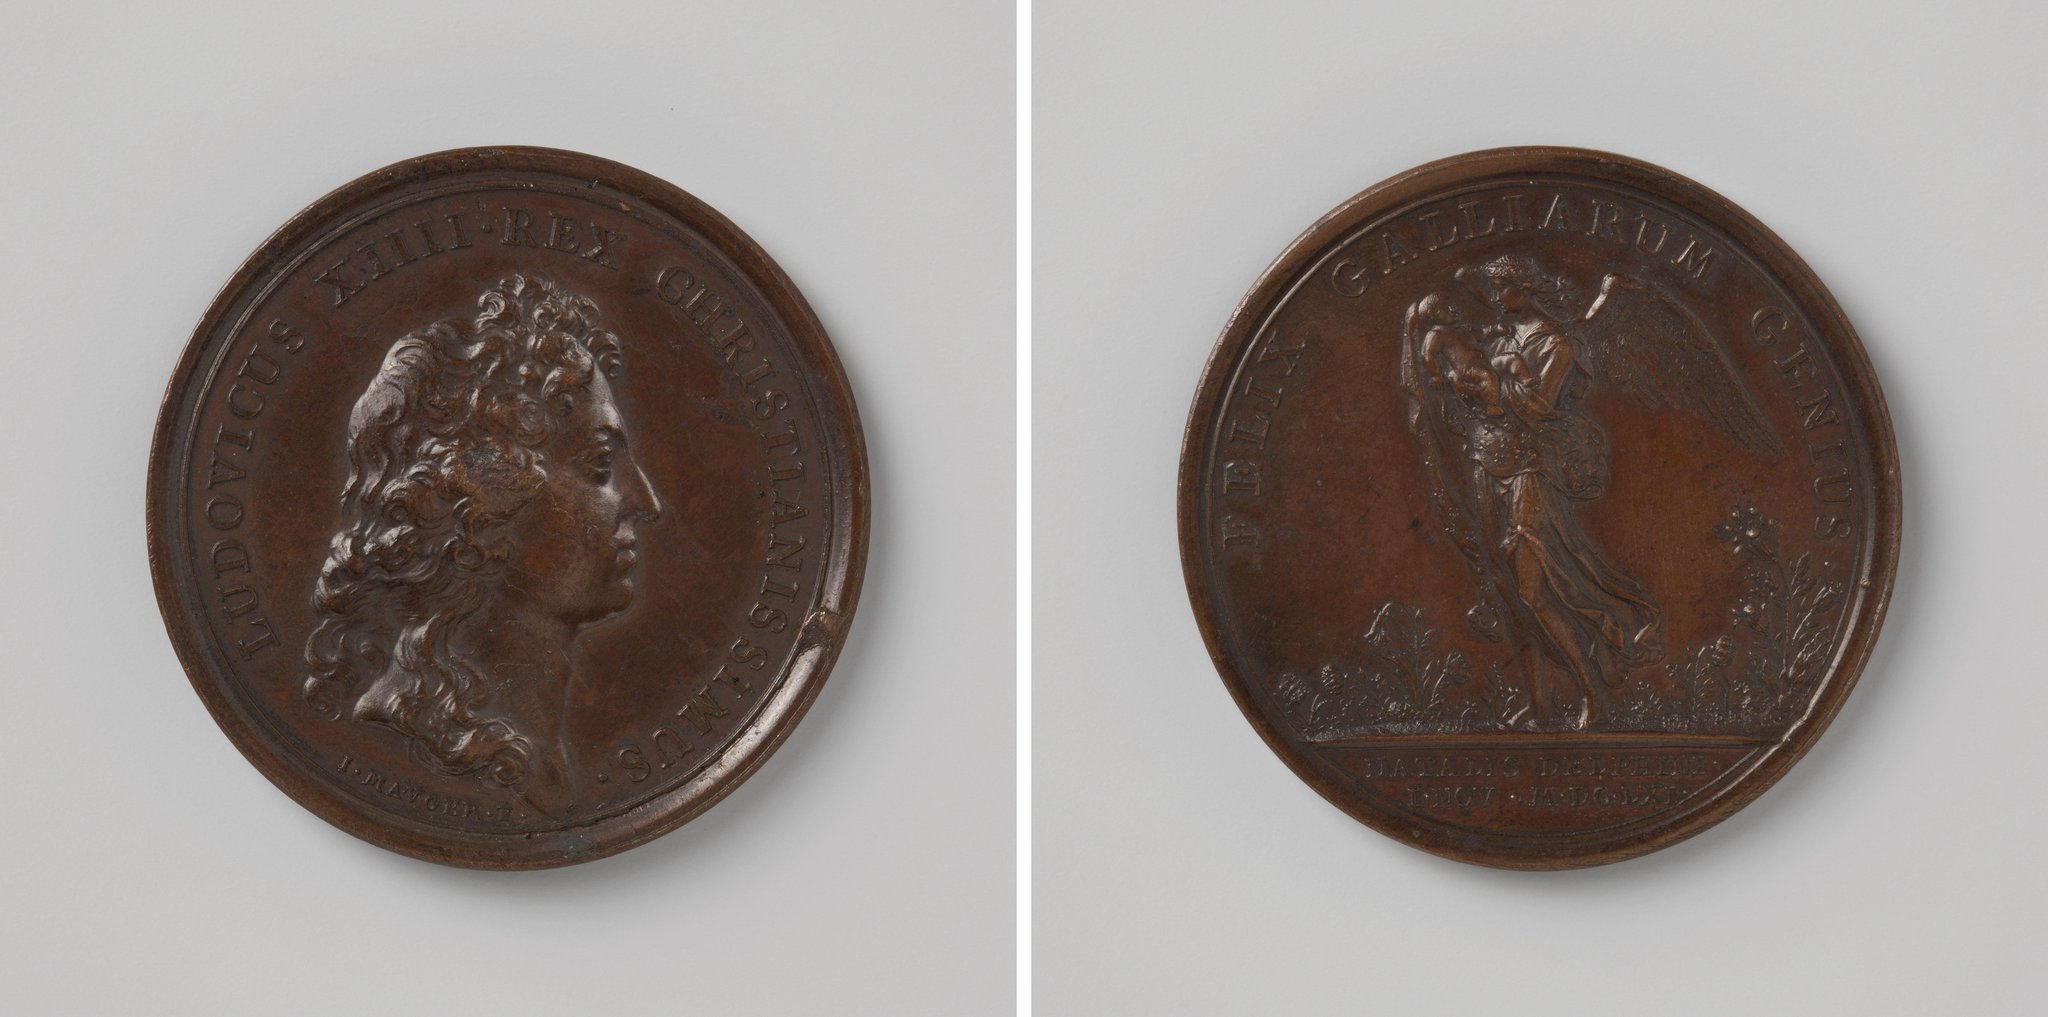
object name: history medal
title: Geboorte van de Dauphin van Frankrijk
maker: jean mauger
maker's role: medailleur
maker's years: 1648-1722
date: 1699-1703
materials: bronze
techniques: striking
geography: paris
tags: lodewijk xiv (koning van frankrijk), dauphin van frankrijk lodewijk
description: Bronzen penning. Voorzijde: borststuk jongeman (Lodewijk XIV) binnen omschrift. Keerzijde: gevleugelde beschermengel draagt pas geboren kind binnen omschrift; afsnede: opschrift